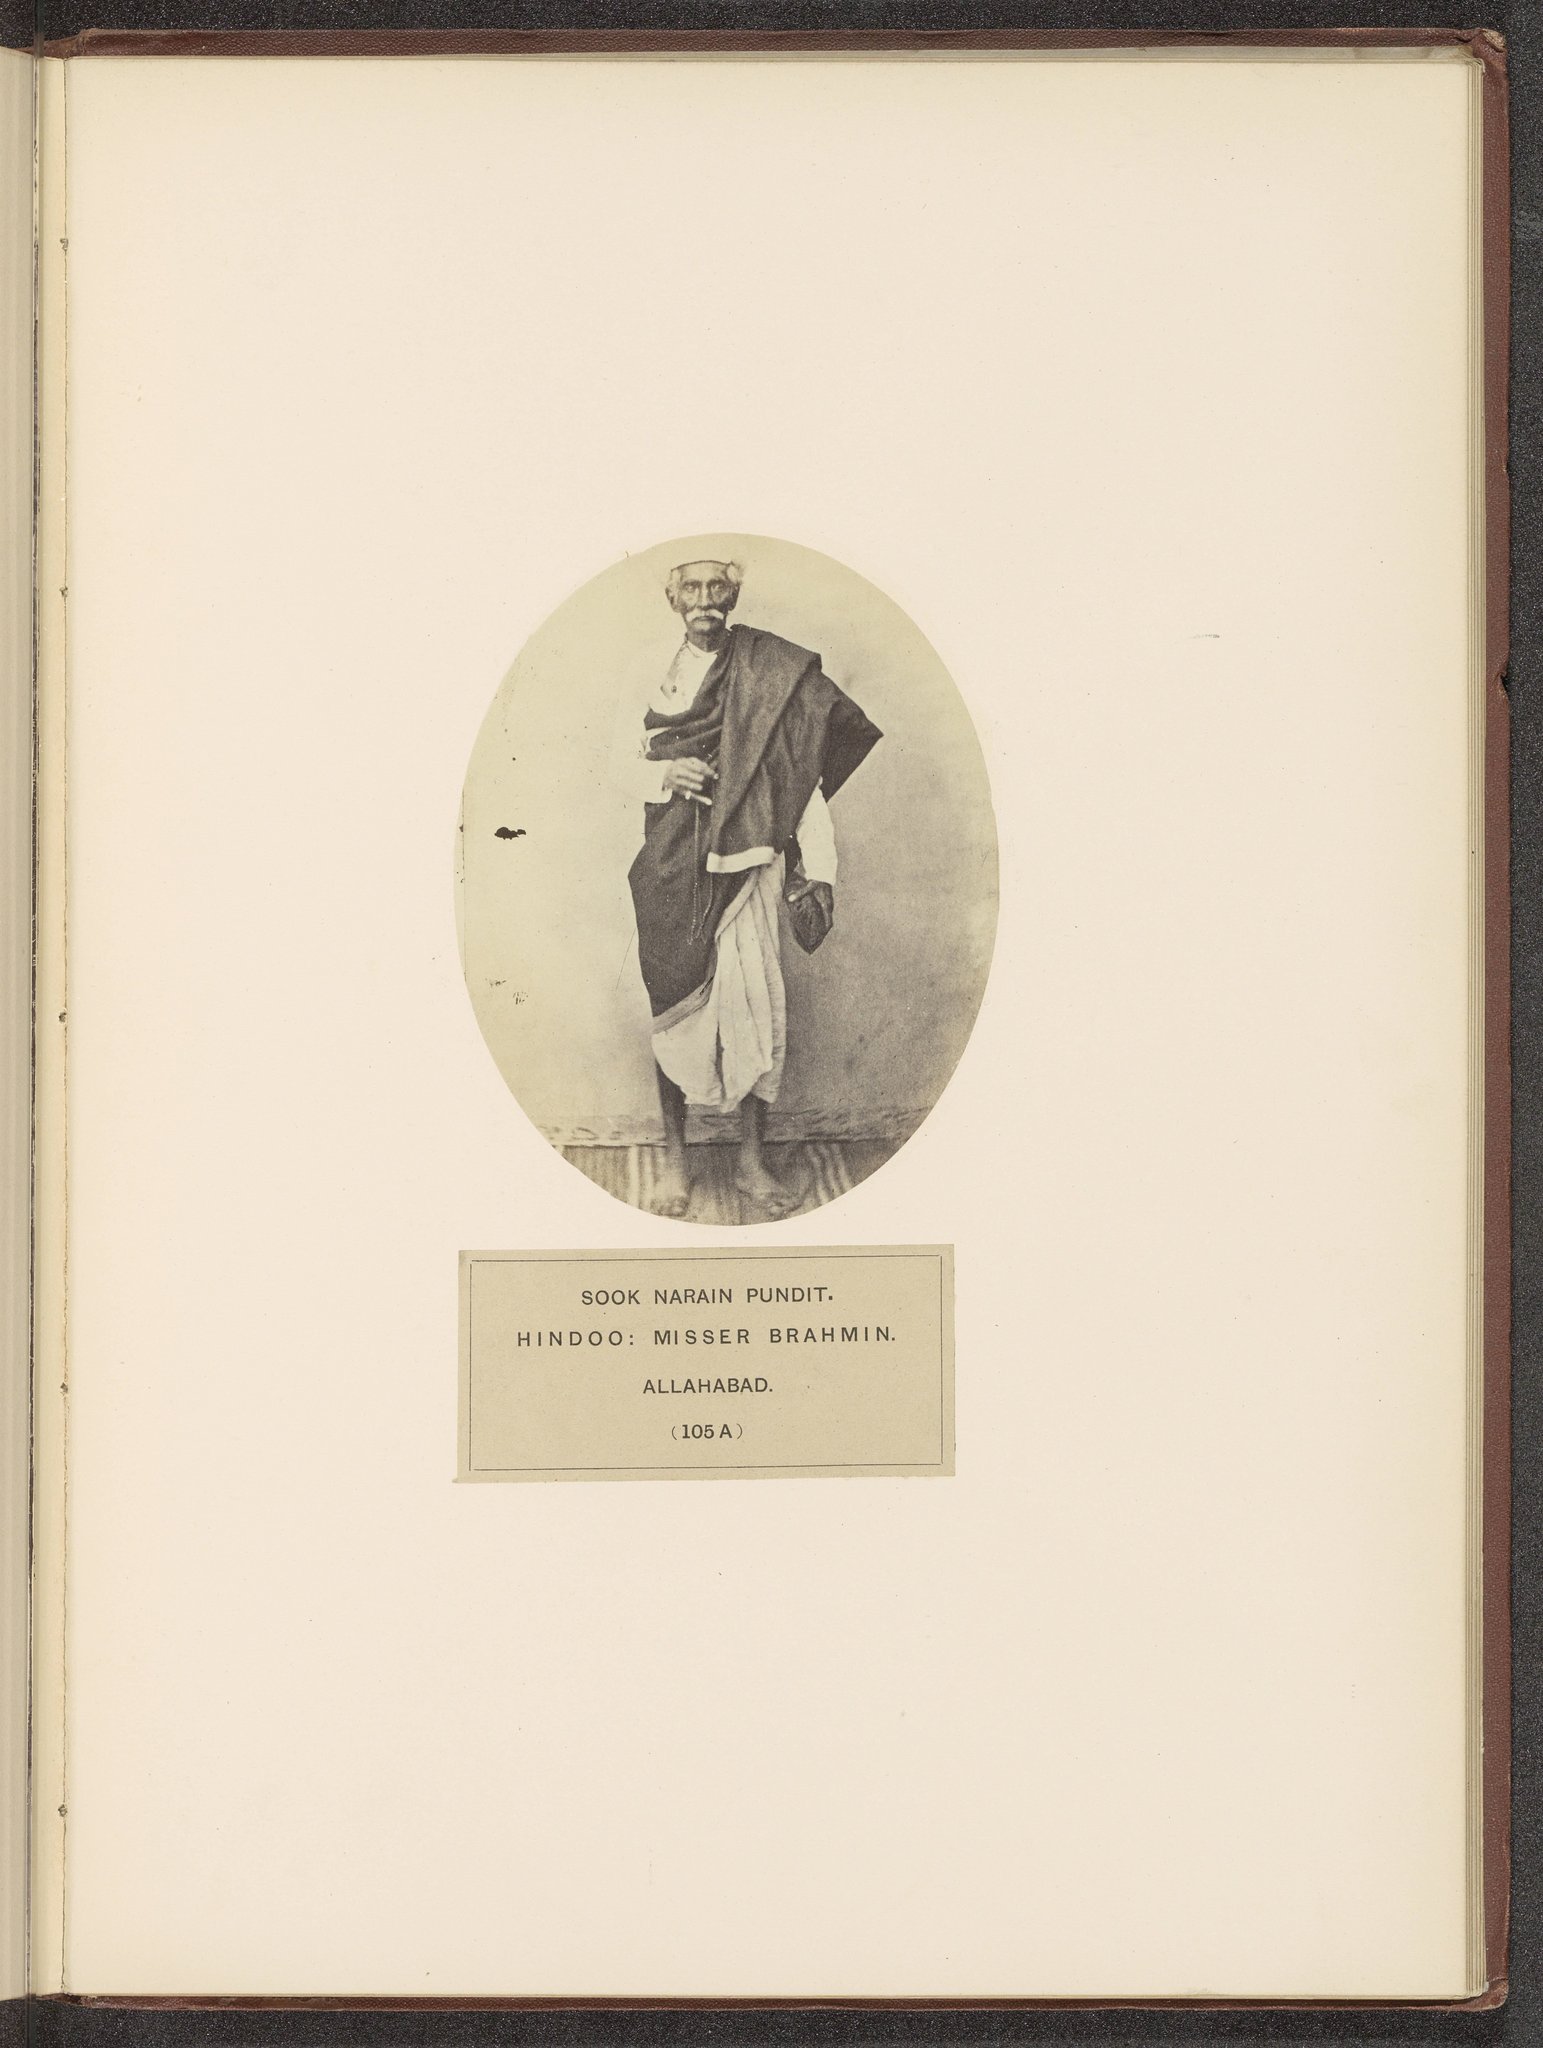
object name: photograph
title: Portrait of Sook Narain, a high priest from Prayagraj, Uttar Pradesh, India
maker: Anonymous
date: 1858-1868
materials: photographic support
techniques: albumen print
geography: allahabad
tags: priest ~ hinduism, buddhism, jainism, human races; peoples; nationalities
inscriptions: inscription: ‘SOOK NARAIN PUNDIT./ HINDOO: MISSER BRAHMIN./ ALLAHABAD.’, number: ‘(105 A )’